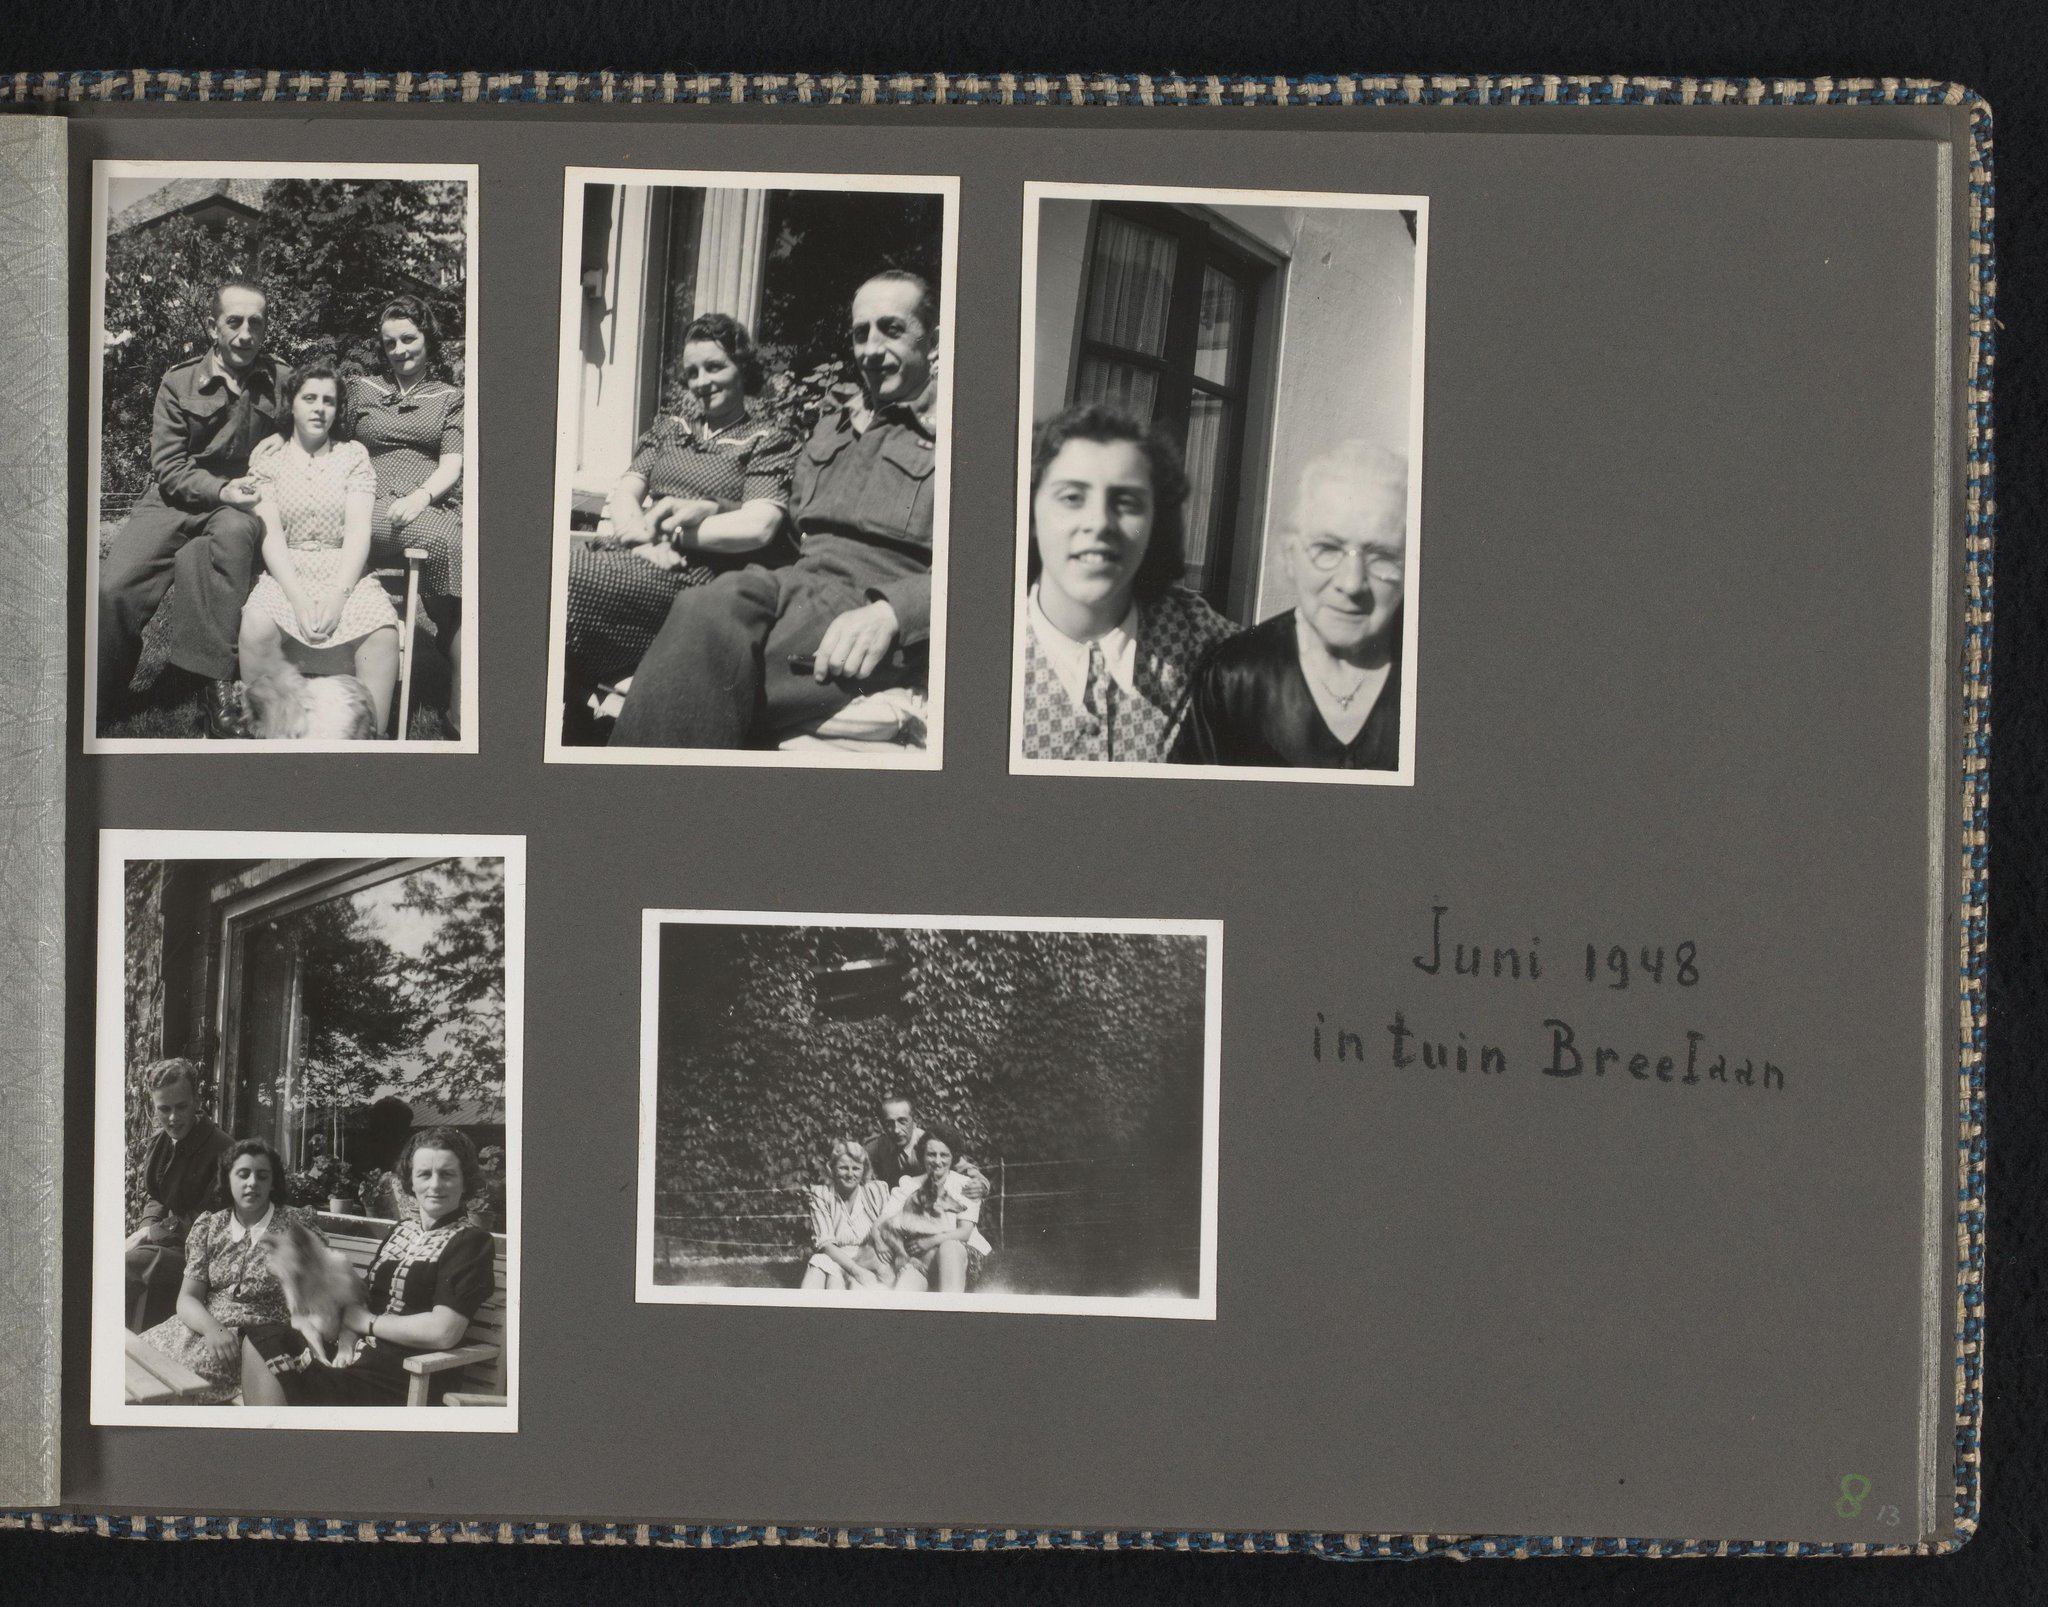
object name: photograph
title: Herenigd gezin in 1948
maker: Anonymous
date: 1906-1948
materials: paper, photographic support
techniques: gelatin silver print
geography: voorschoten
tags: family life at home, prisoner of war (after the battle), voorschoten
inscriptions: date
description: Albumblad met vijf foto's uit 1948 van het herenigde gezin. De vader in militair uniform weer thuis bij zijn familie. Onderdeel van het fotoalbum van het gezin van een Nederlandse officier in krijgsgevangenschap in Kamp Stanislau.